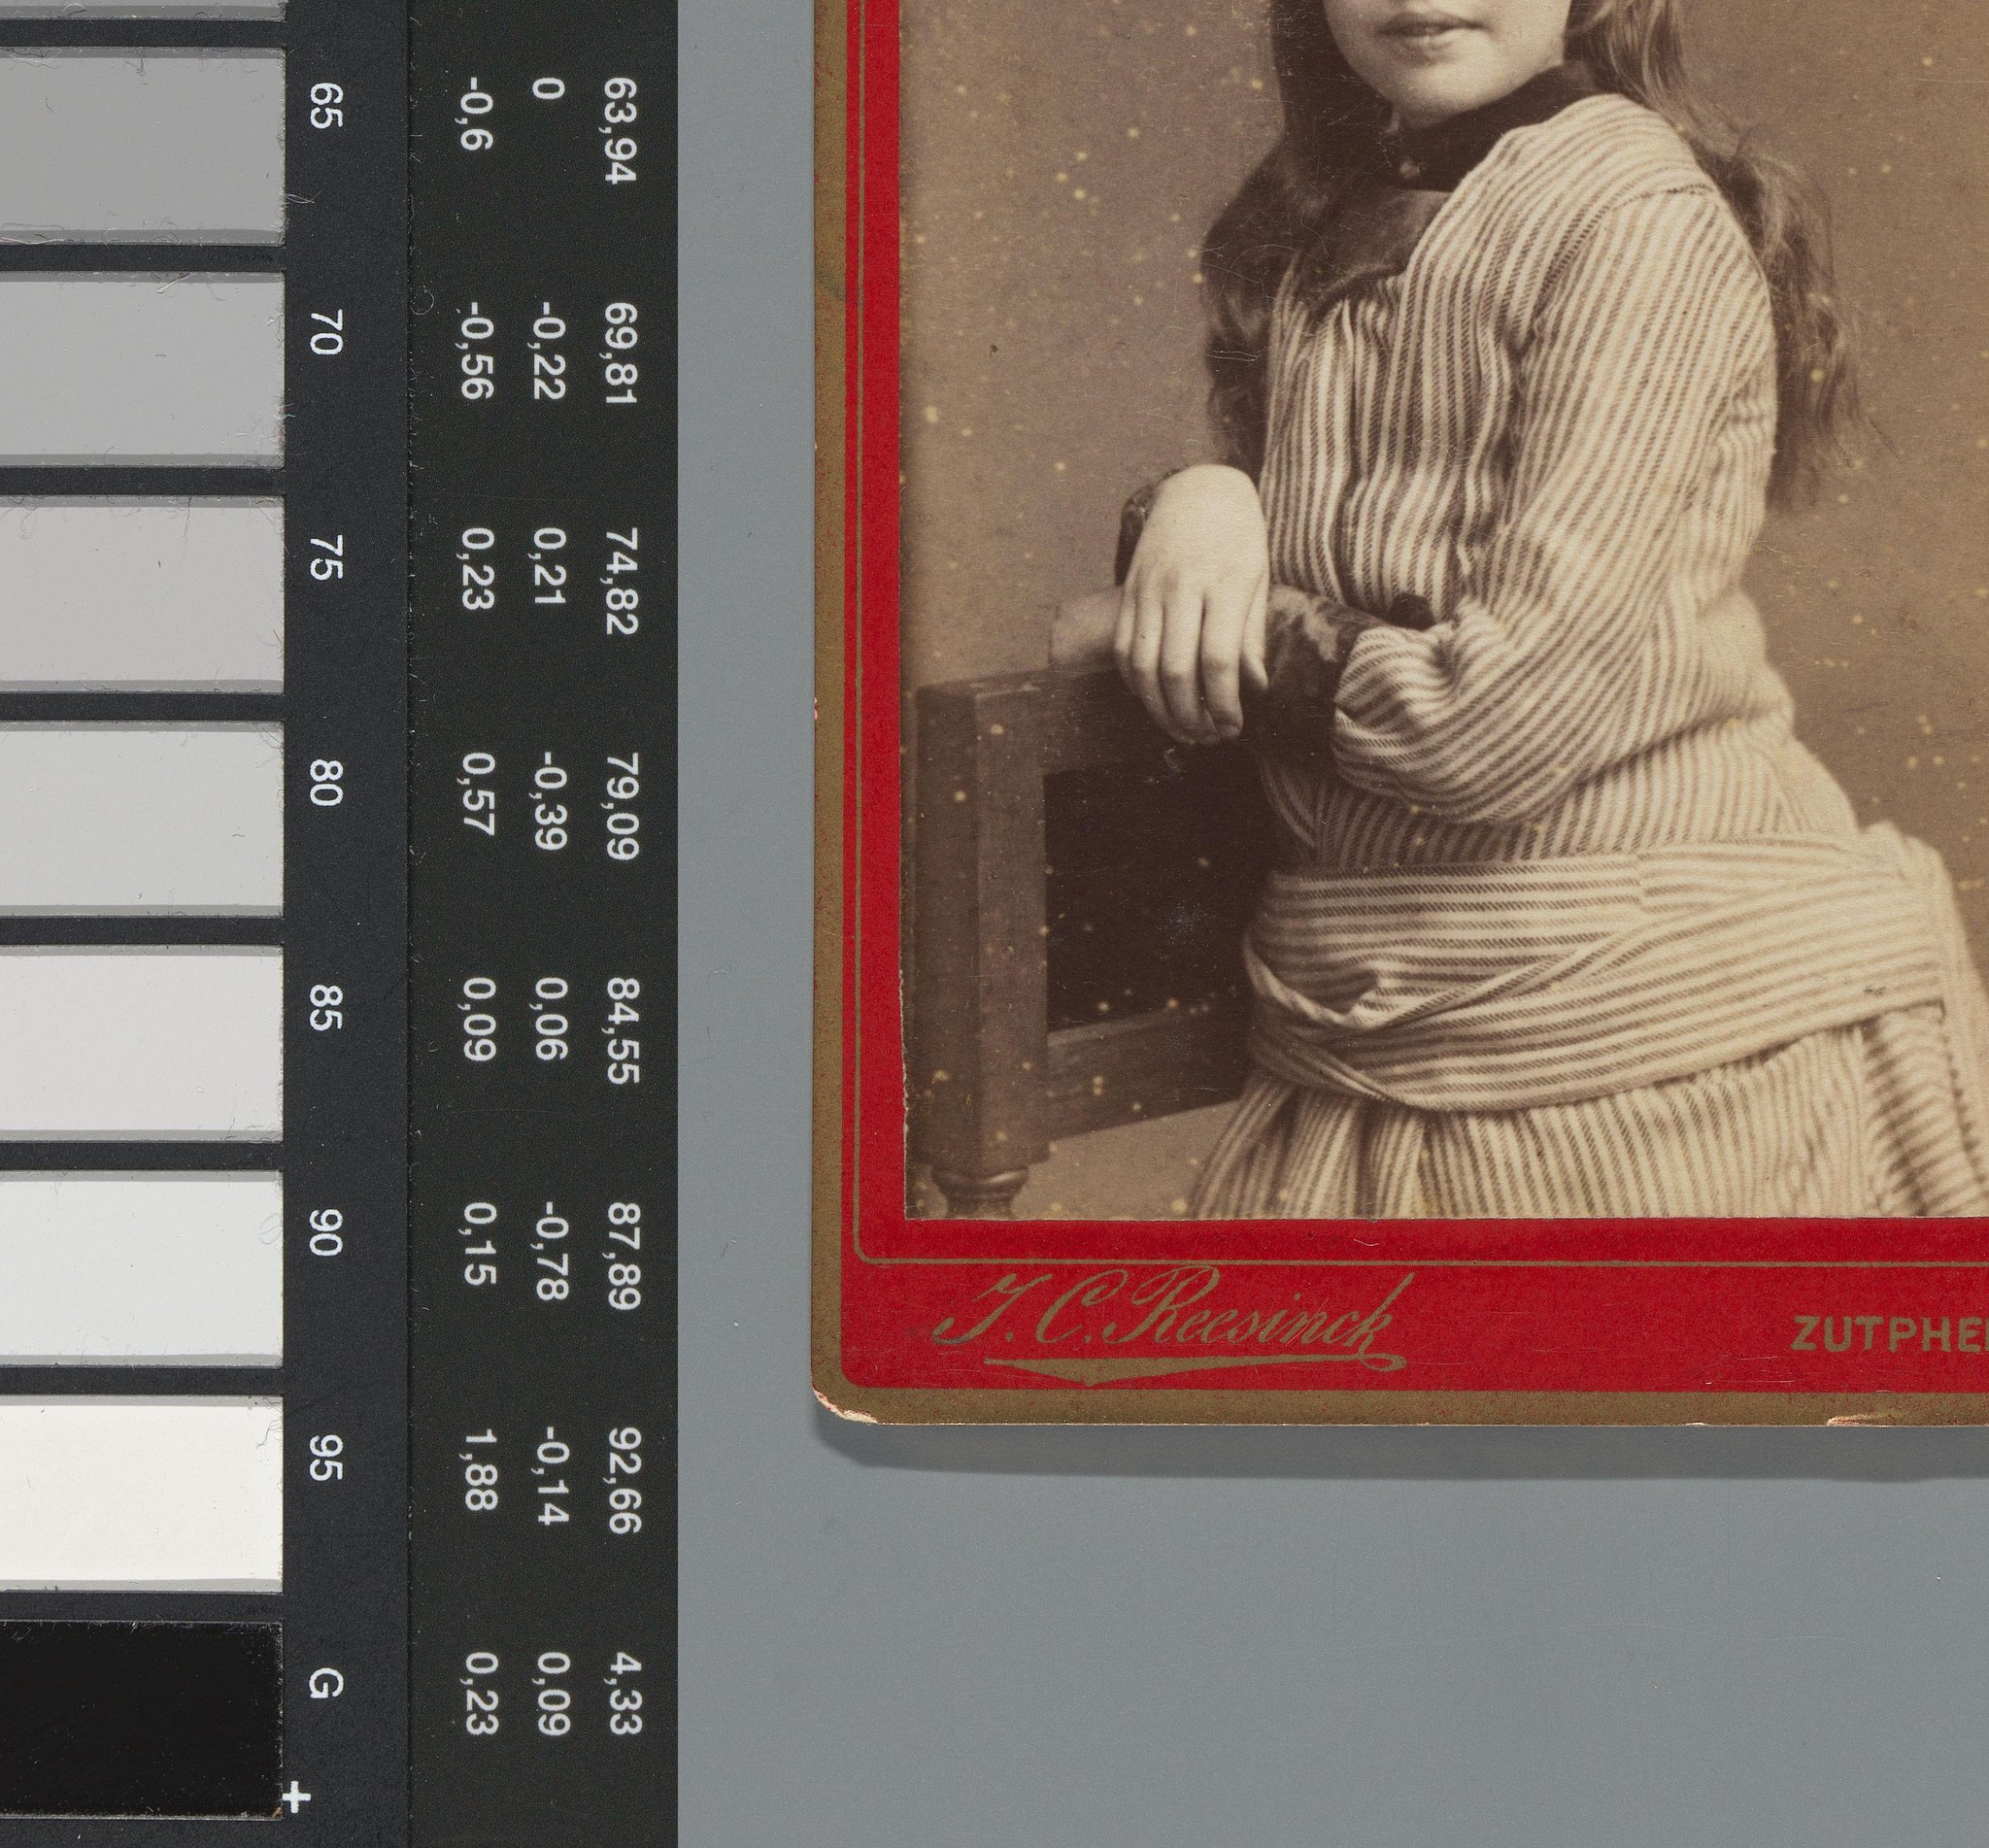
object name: photograph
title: Portret van tante Leo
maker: johan christiaan reesinck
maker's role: fotograaf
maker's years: 1838-1922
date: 1855-1910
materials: cardboard, photographic support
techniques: albumen print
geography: zutphen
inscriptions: inscription: ‘tante Leo’, name: ‘J.C. Reesinck / ZUTPHEN / Berkelkade B. 300. / Het cliché blijft voor nabestelling bewaard.’